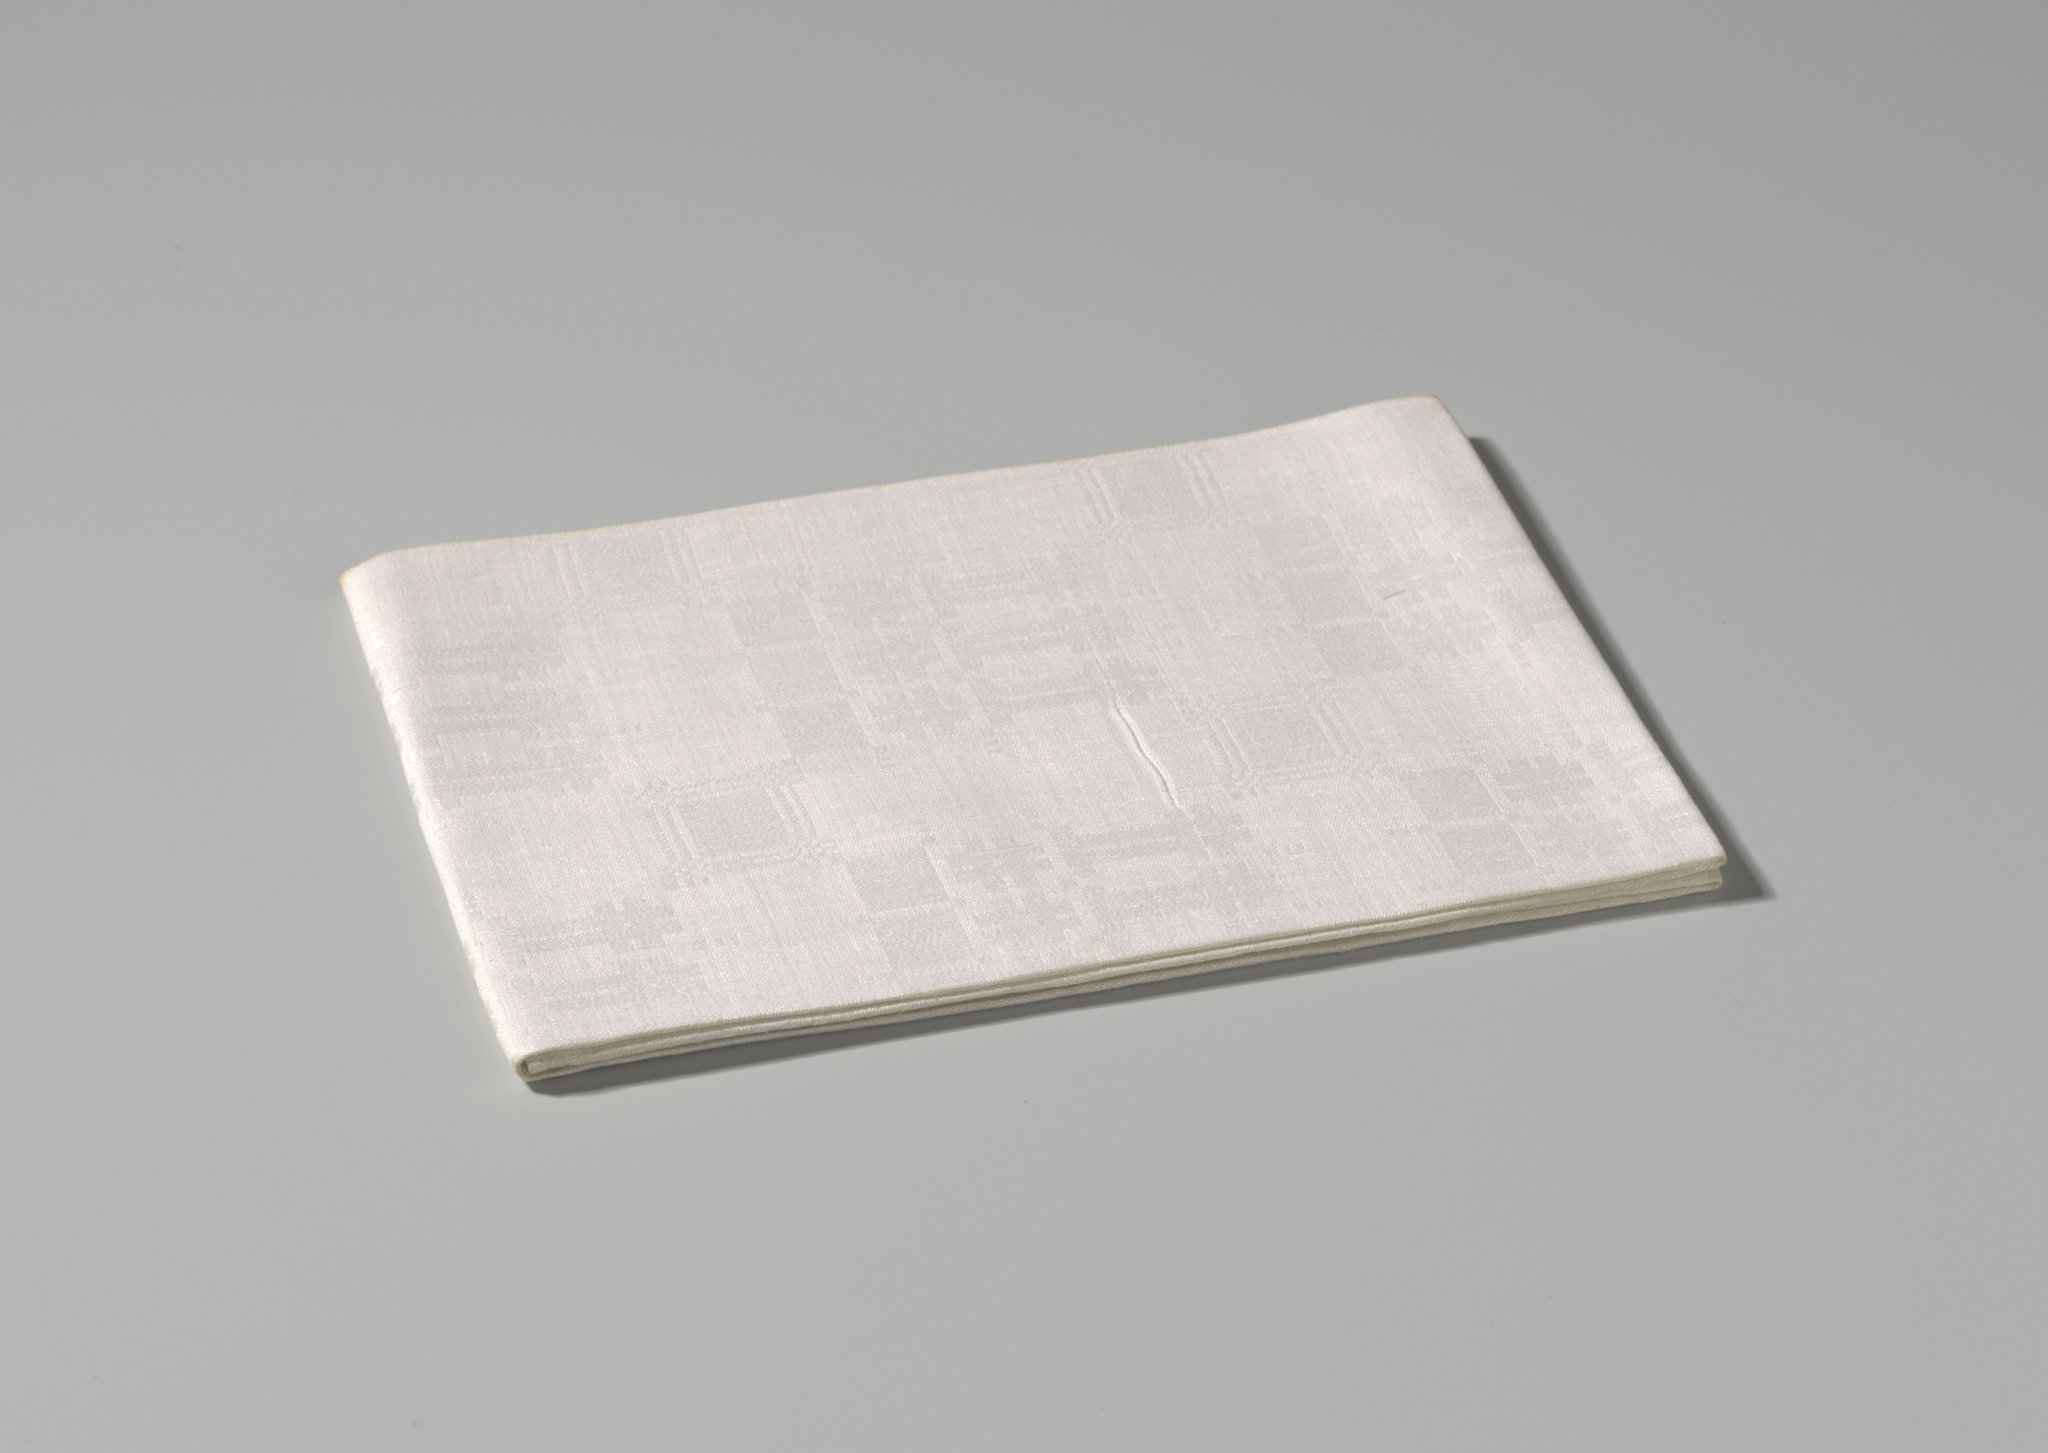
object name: napkin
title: Servet van linnen met pellenpatroon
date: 1725-1769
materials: linen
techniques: peeled fabric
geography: northern netherlands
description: wit linnen servet met pellen patroon, merk kroon ARVG 31